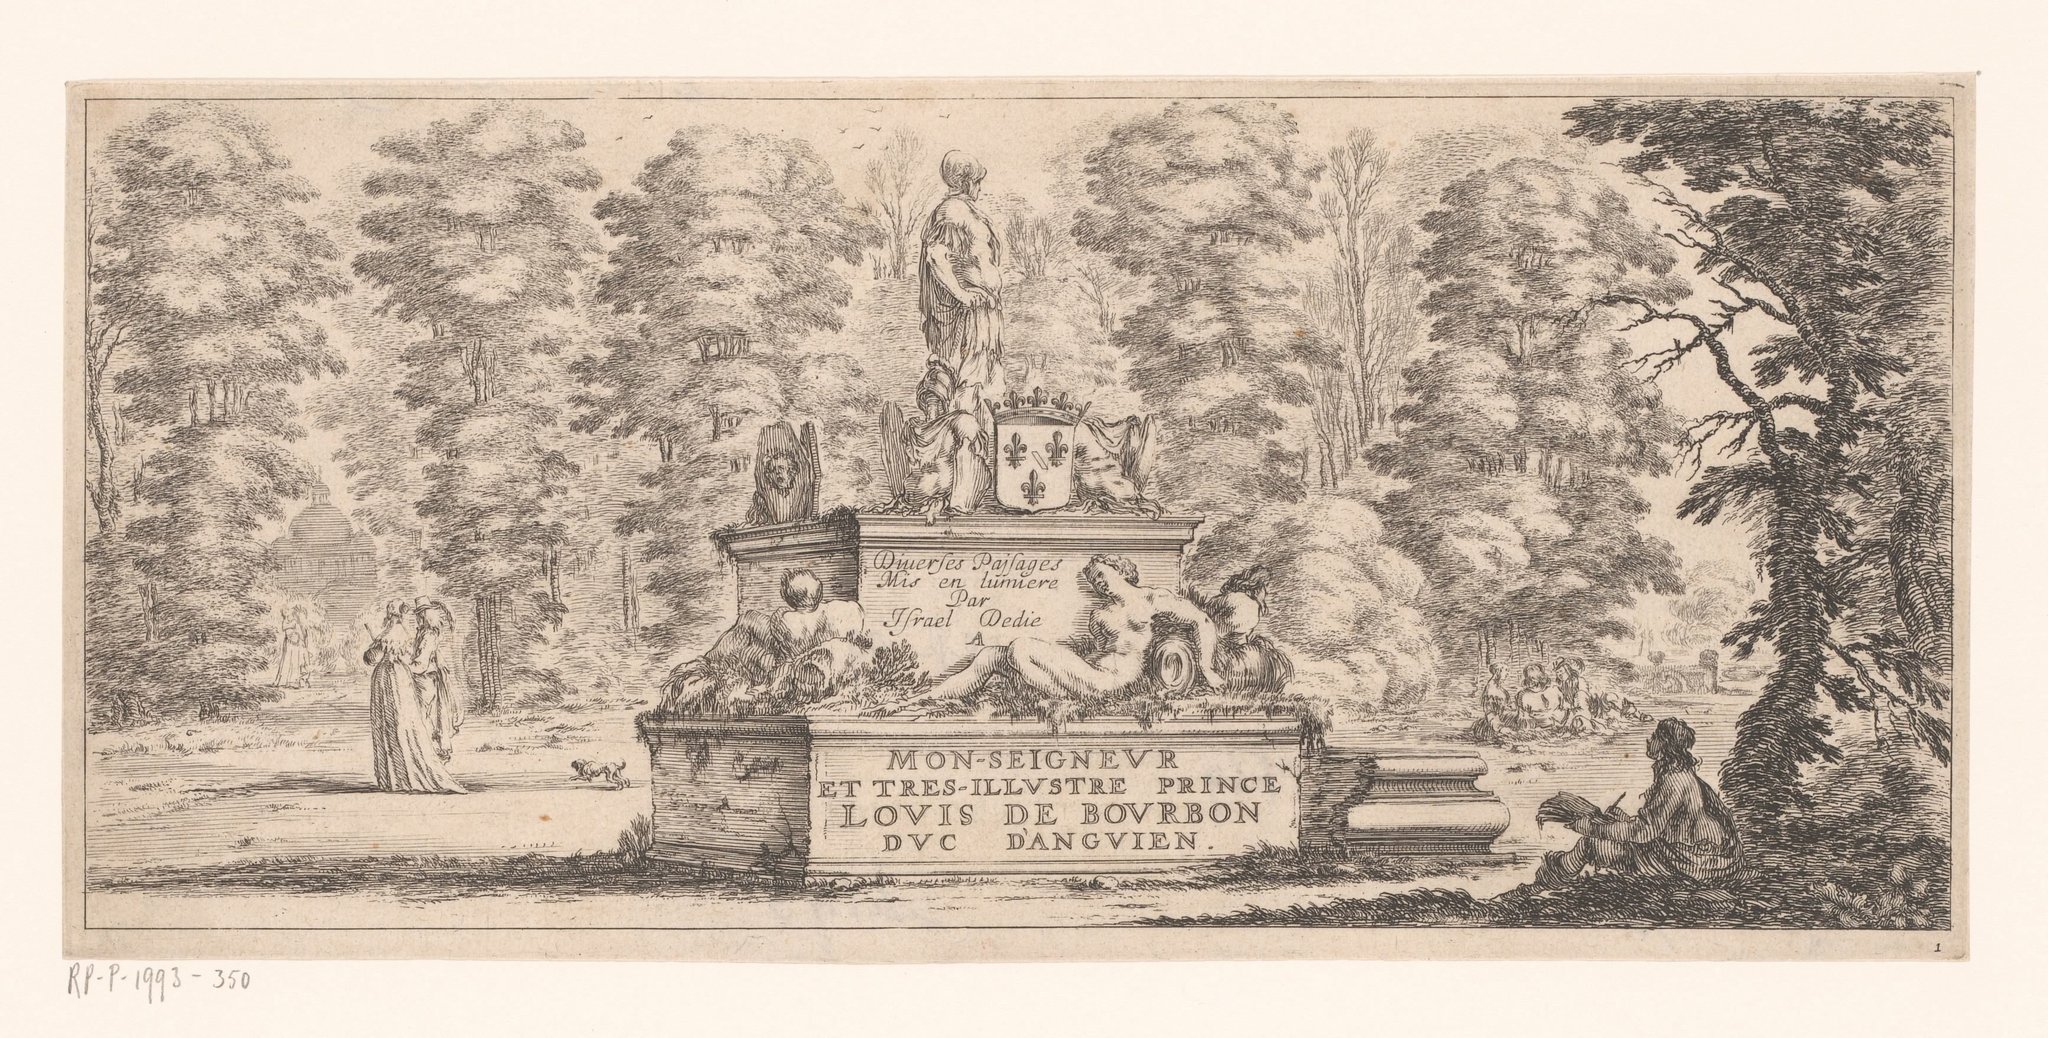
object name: titelprent, frontispice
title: Titelprent met parklandschap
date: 1643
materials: paper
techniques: engraving, etching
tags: drawing (+ artist at work), park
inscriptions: collector's mark: Lugt 2228